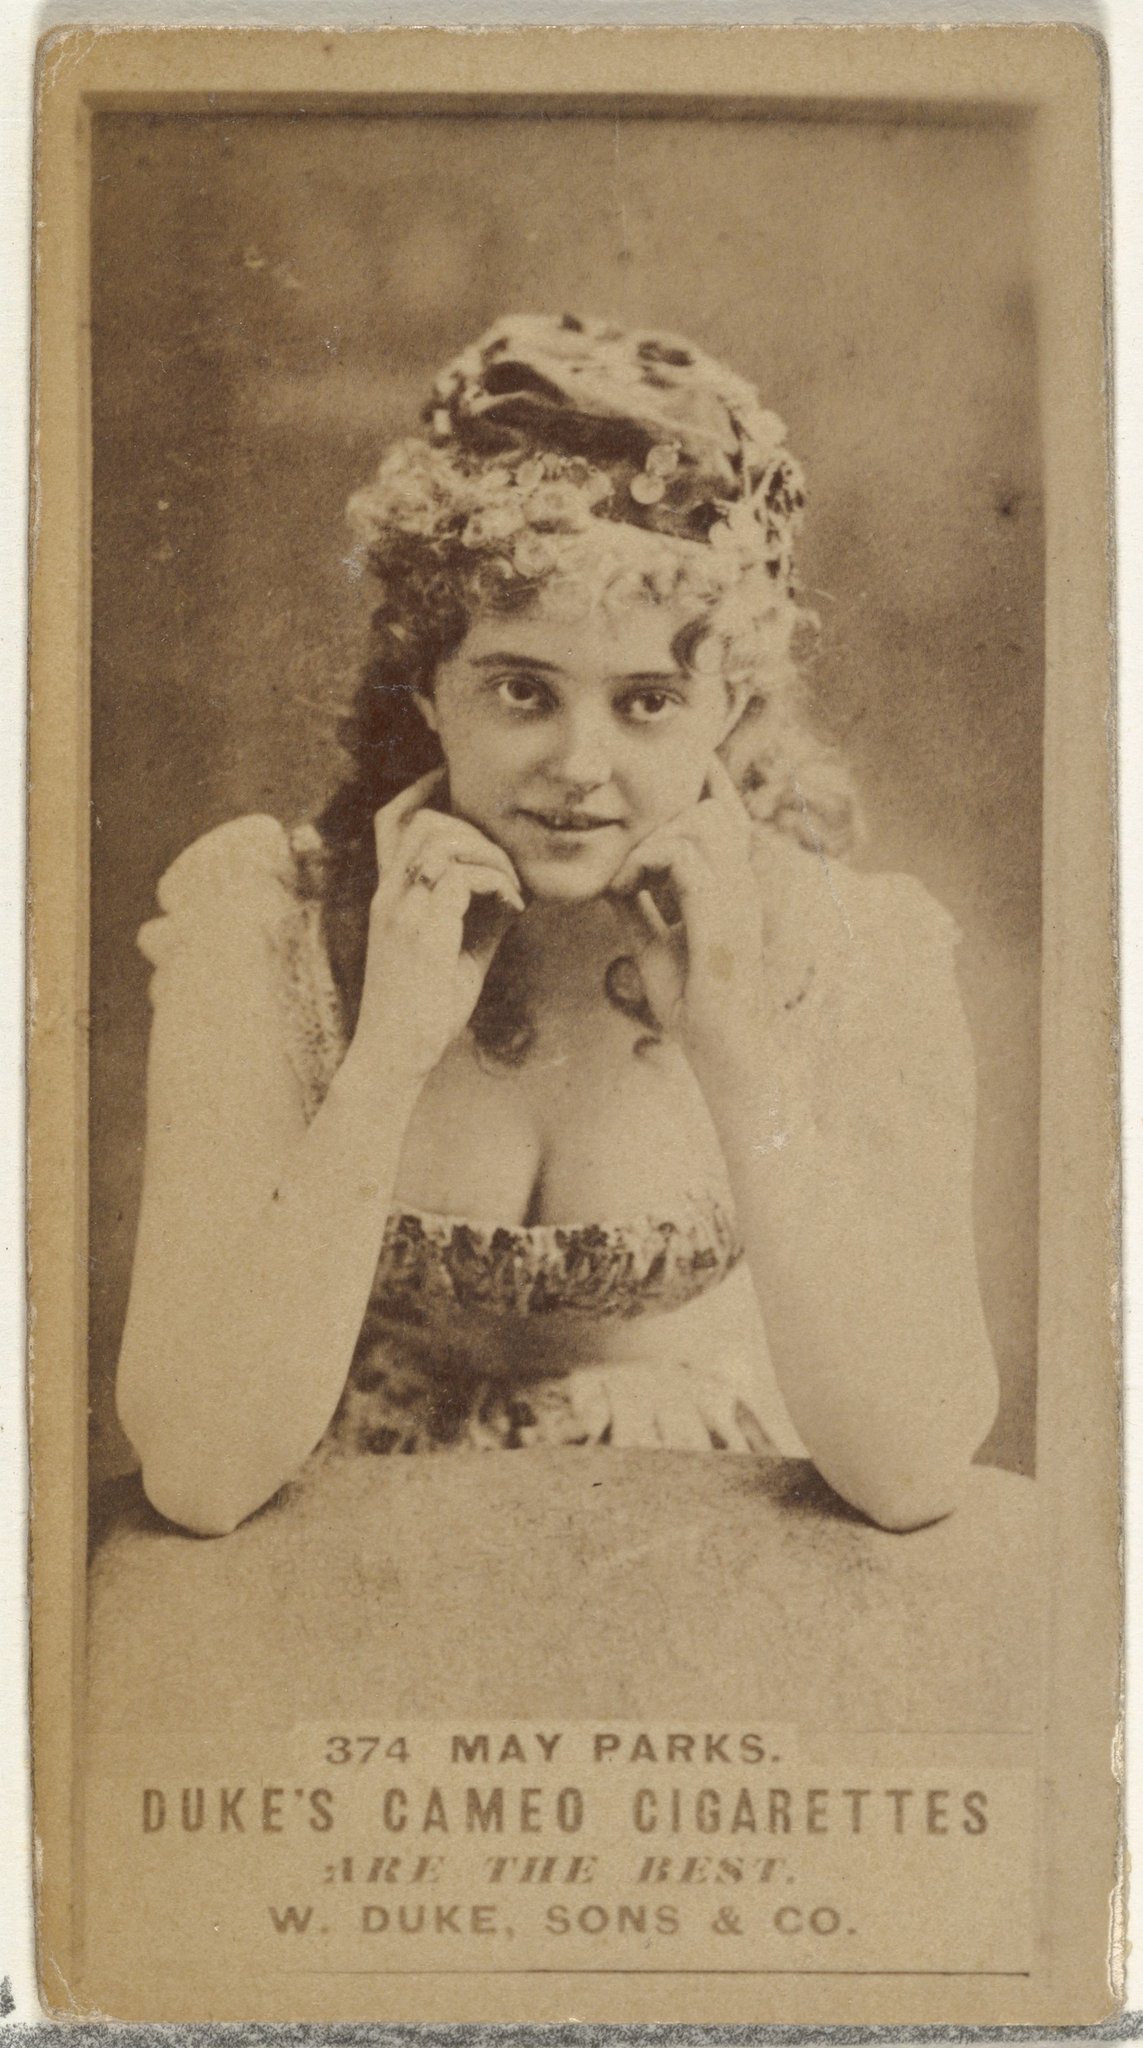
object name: photograph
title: Card Number 374, May Parks, from the Actors and Actresses series (N145-5) issued by Duke Sons & Co. to promote Cameo Cigarettes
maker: w. duke, sons & co.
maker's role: publisher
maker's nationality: american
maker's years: 1870-1920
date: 1880-1889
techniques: albumen silver print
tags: portraits,women,actresses